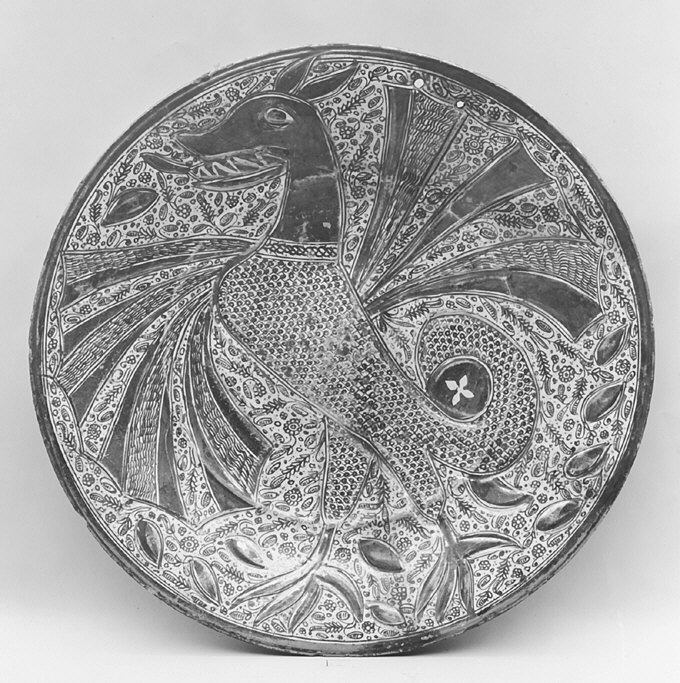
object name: dish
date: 1526-1550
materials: earthenware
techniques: luster painting, glazing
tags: animals